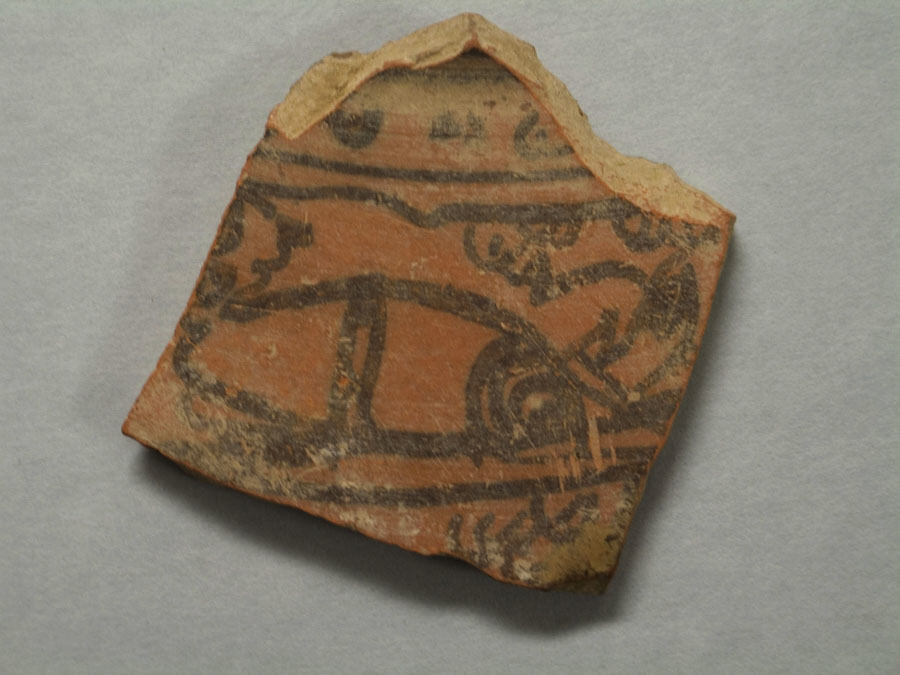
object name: shard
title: Shard: Shoulder of Vessel with Offerer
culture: pakistani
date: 301-500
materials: terracotta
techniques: painting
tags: gandhara